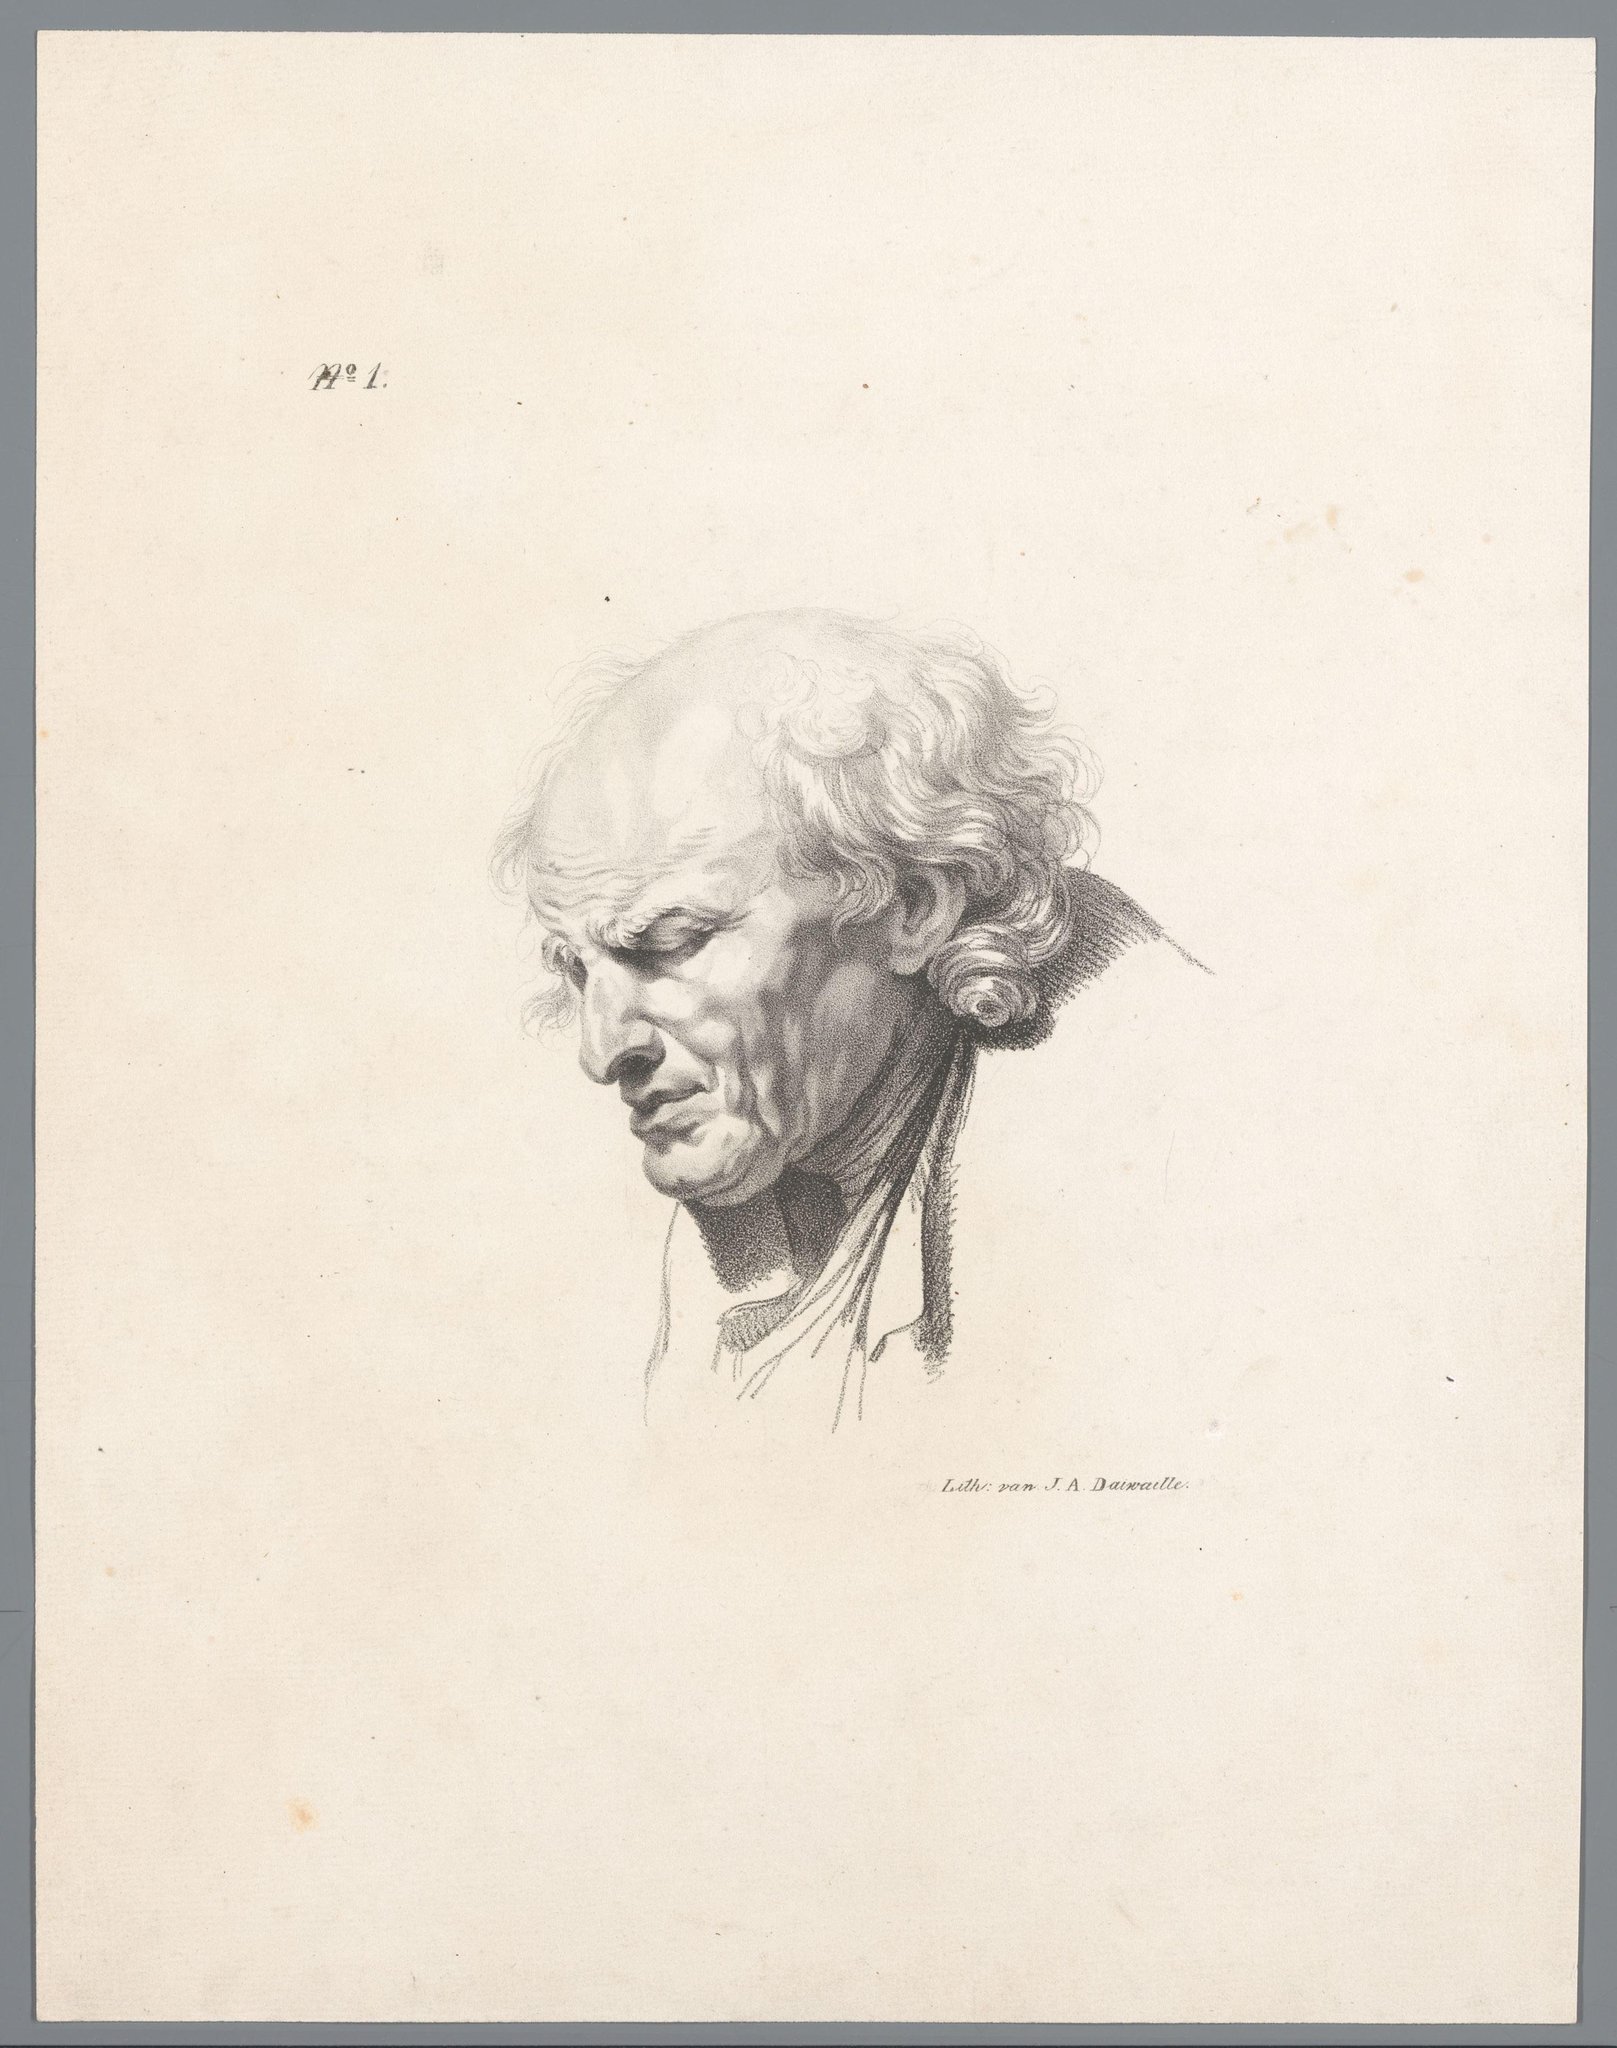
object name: print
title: Hartstochten na J.B. Greuze Nummer Twee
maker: jean augustin daiwaille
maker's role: draughtsman, print maker, printer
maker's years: 1786-1850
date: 1820-1830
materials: paper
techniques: lithograph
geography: amsterdam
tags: old man (+ relations with sad character (expressive connotations))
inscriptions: collector's mark: Lugt 2760, collector's mark: Lugt 2228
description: 'Hartstochten na J.B. Greuze' bestaat uit twee of drie genummerde reeksen. (Sommige nummers komen drie keer voor op drie verschillende afbeeldingen.) Binnen deze omslag bevinden zich achttien verschillende afbeeldingen. Mogelijk heeft dit te maken met de twee momenten waarop Daiwaille de reeks uitgaf, ten tijden van zijn directeurschap aan de Rijksakademie in Amsterdam en daarna als zelfstandige. De omslag behoort waarschijnlijk bij een van deze twee series. Zie Marres-Schretlen in het Bulletin van het Rijksmuseum.